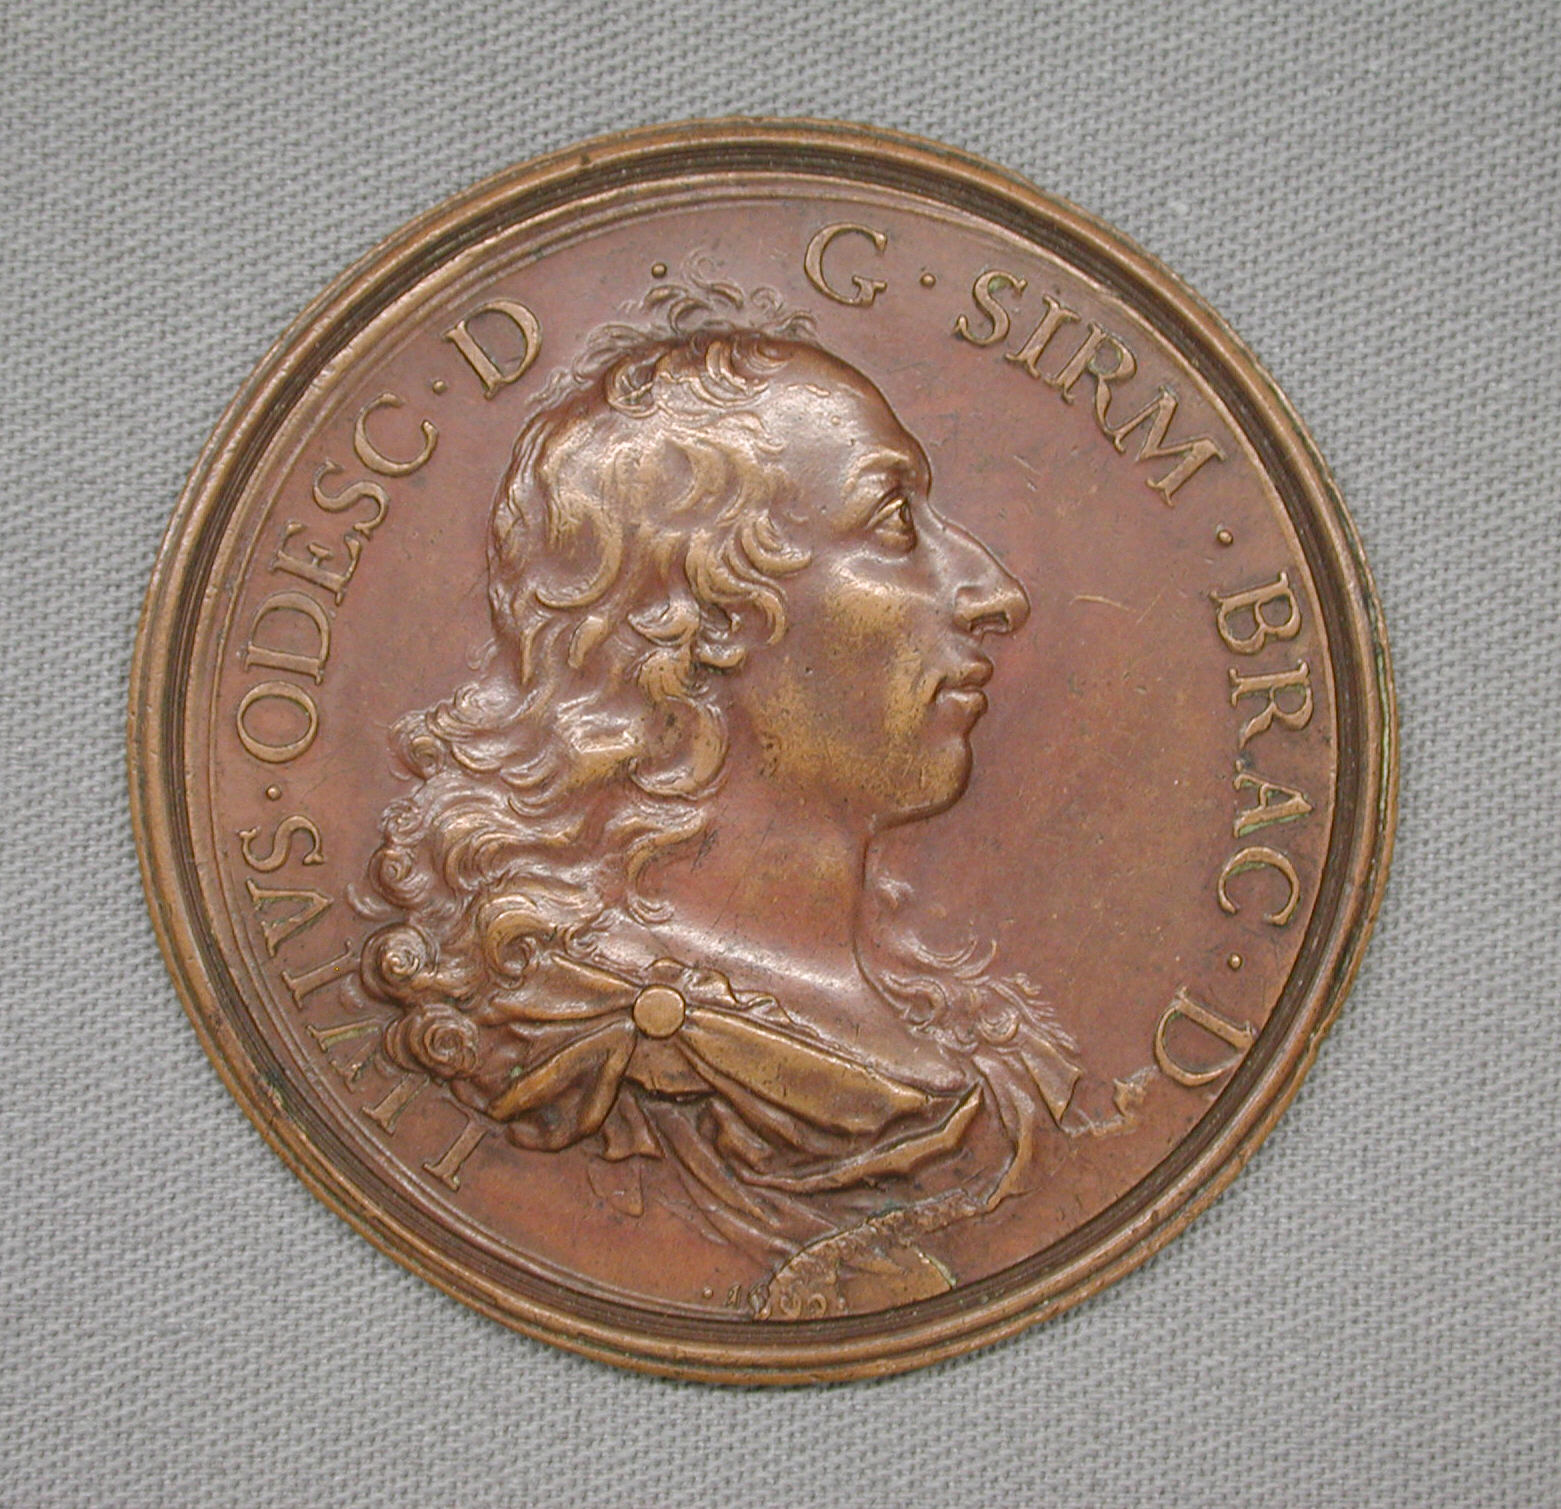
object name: medal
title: In honor of Livio Odescalchi (1652–1713), nephew of Pope Innocent XI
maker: giovanni martino hamerani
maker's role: artist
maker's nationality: italian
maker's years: 1646-1705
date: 1699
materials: bronze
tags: men,profiles,boats